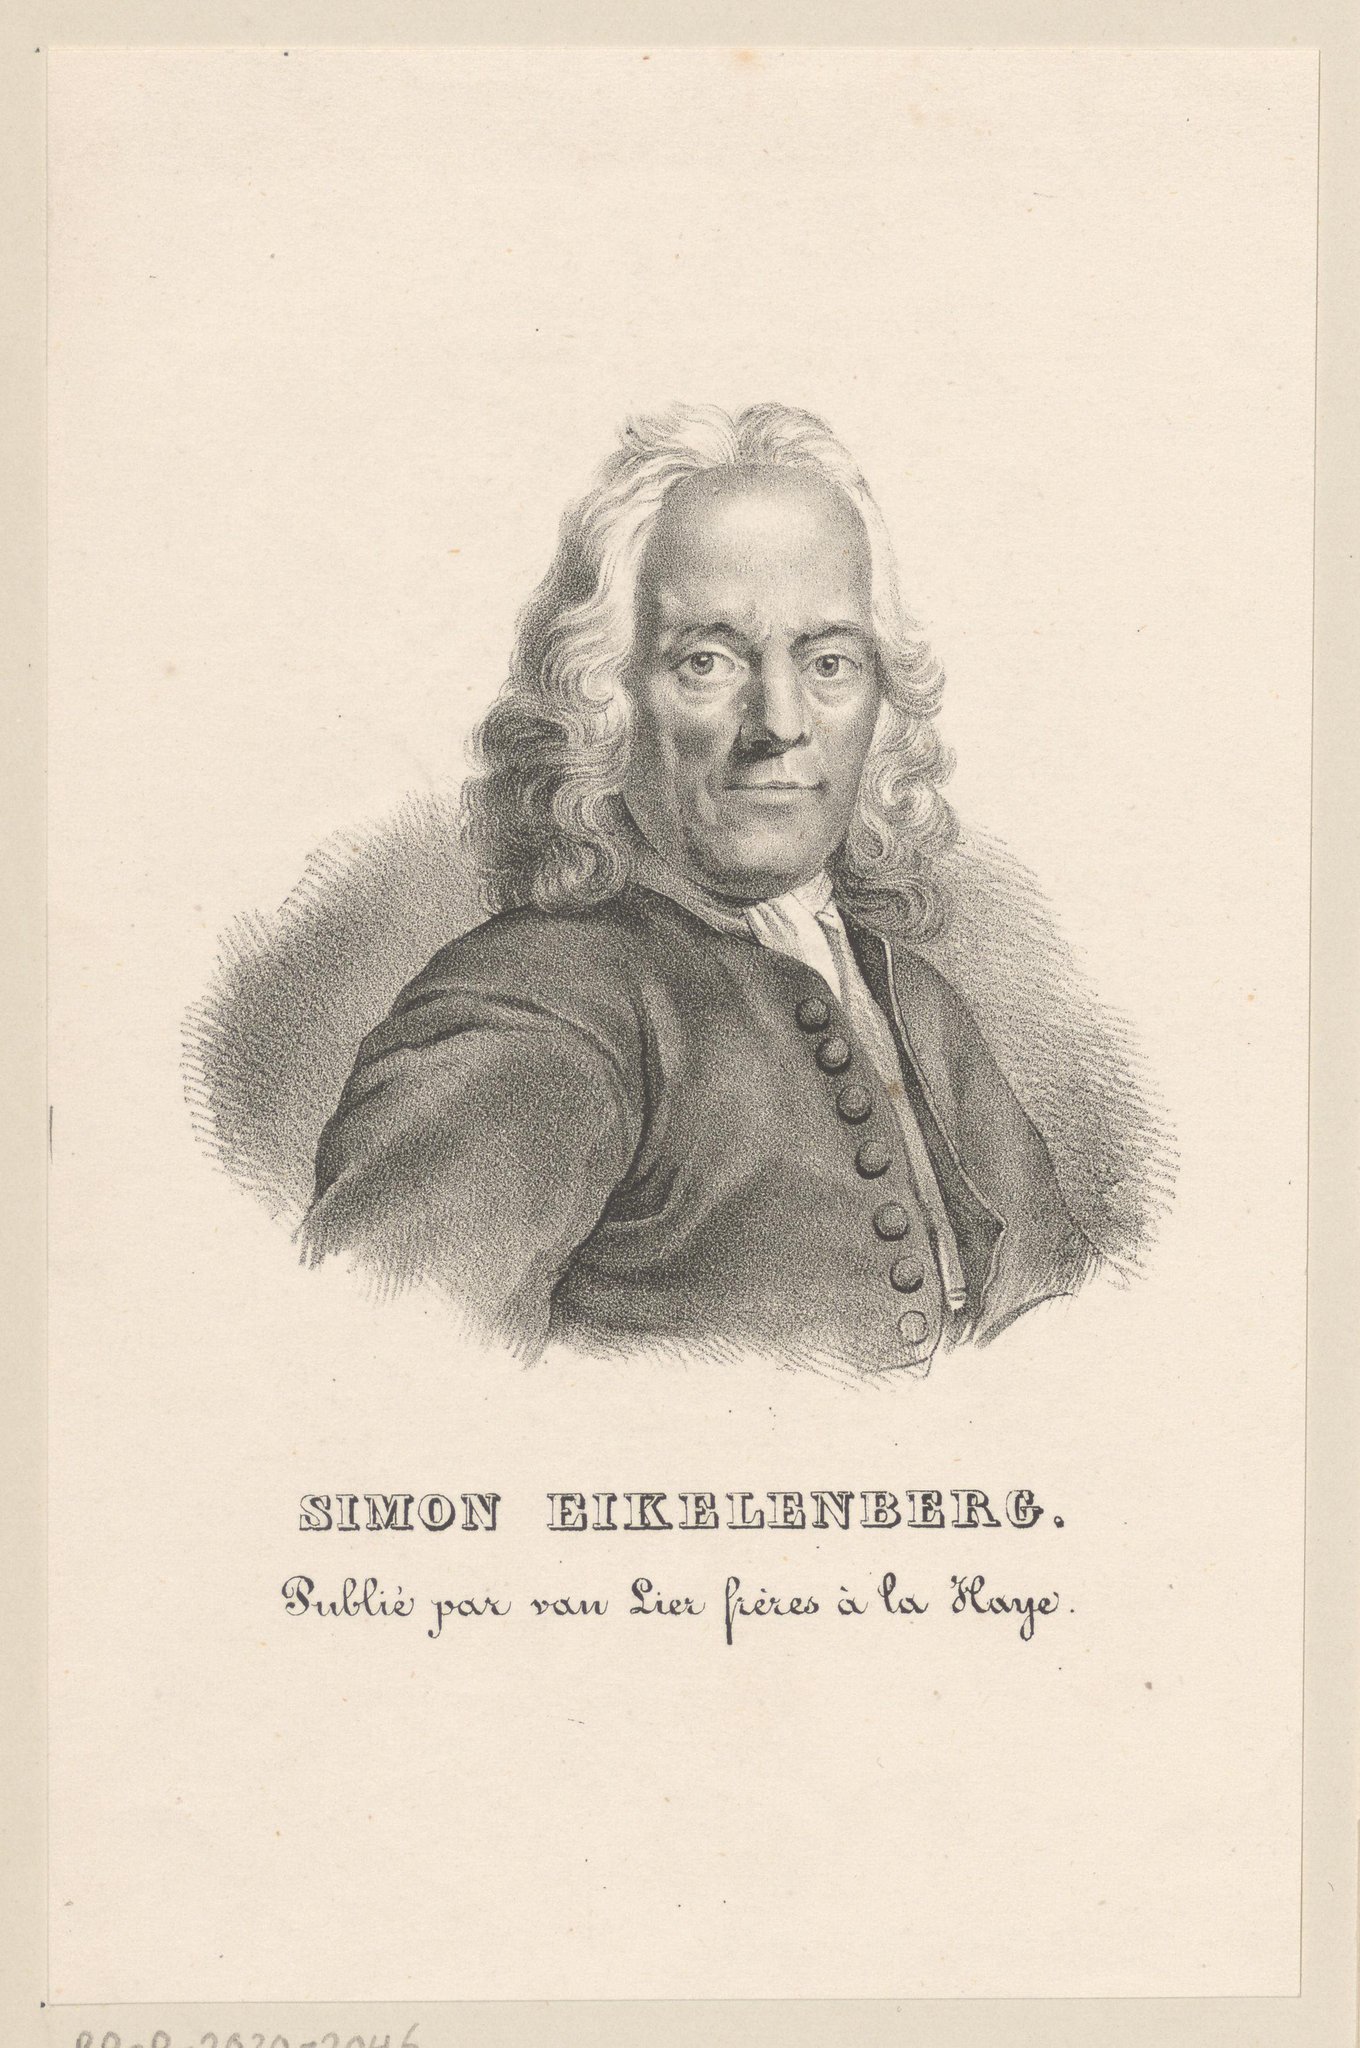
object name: print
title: Portret van Simon Eikelenberg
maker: Anonymous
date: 1833-1850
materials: paper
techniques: lithograph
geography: the hague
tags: painter, draughtsman, simon eikelenberg, historical persons, portrait of a writer